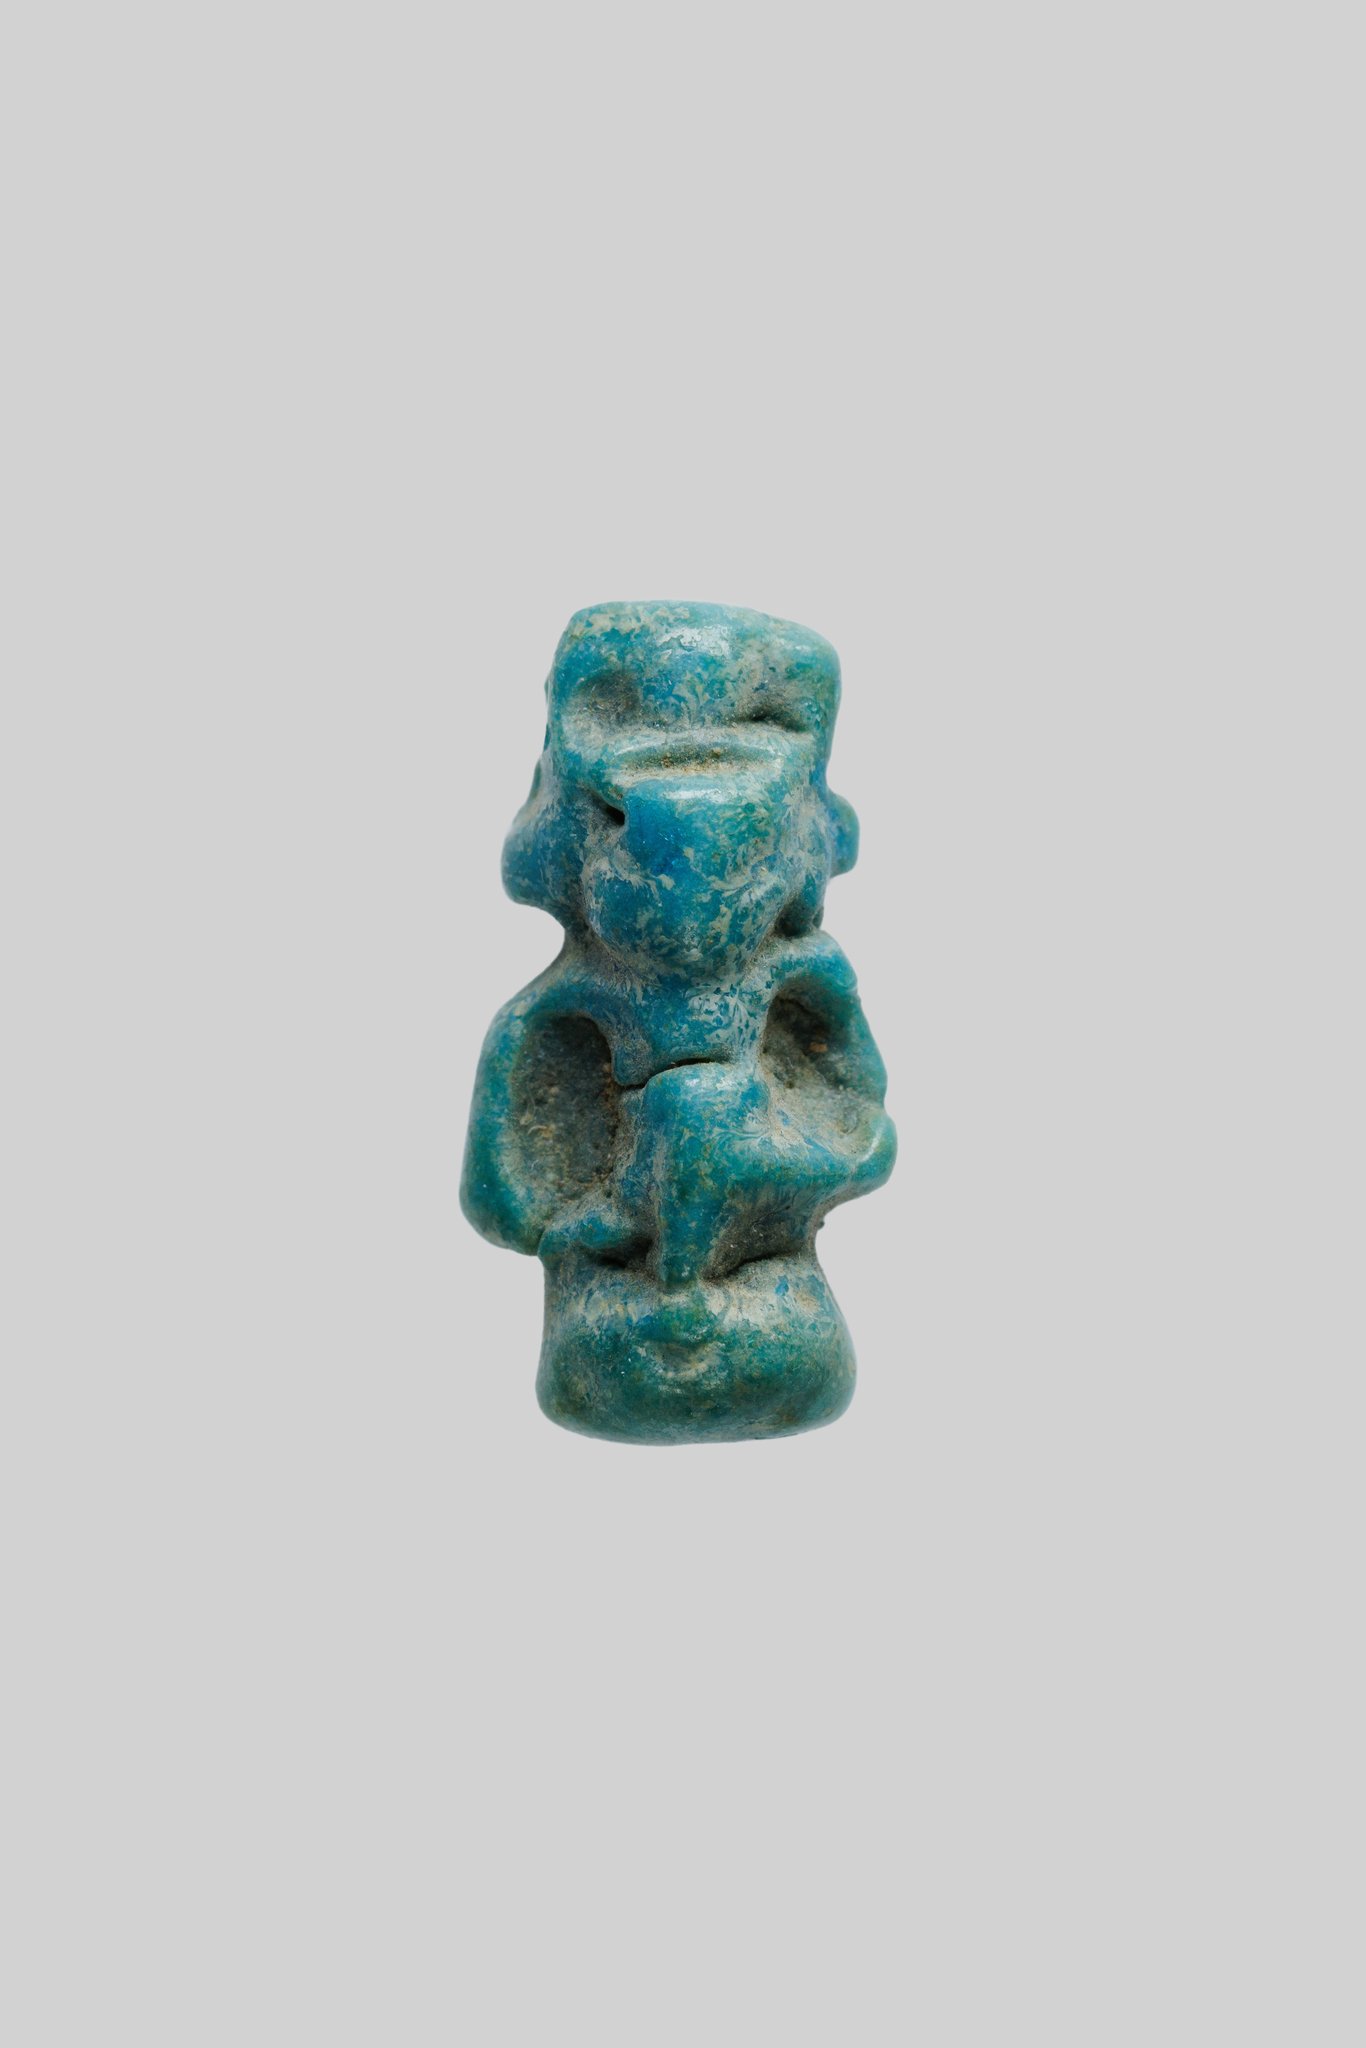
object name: amulet, sakhmet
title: Sakhmet amulet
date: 1295-1070 BCE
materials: faience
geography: egypt